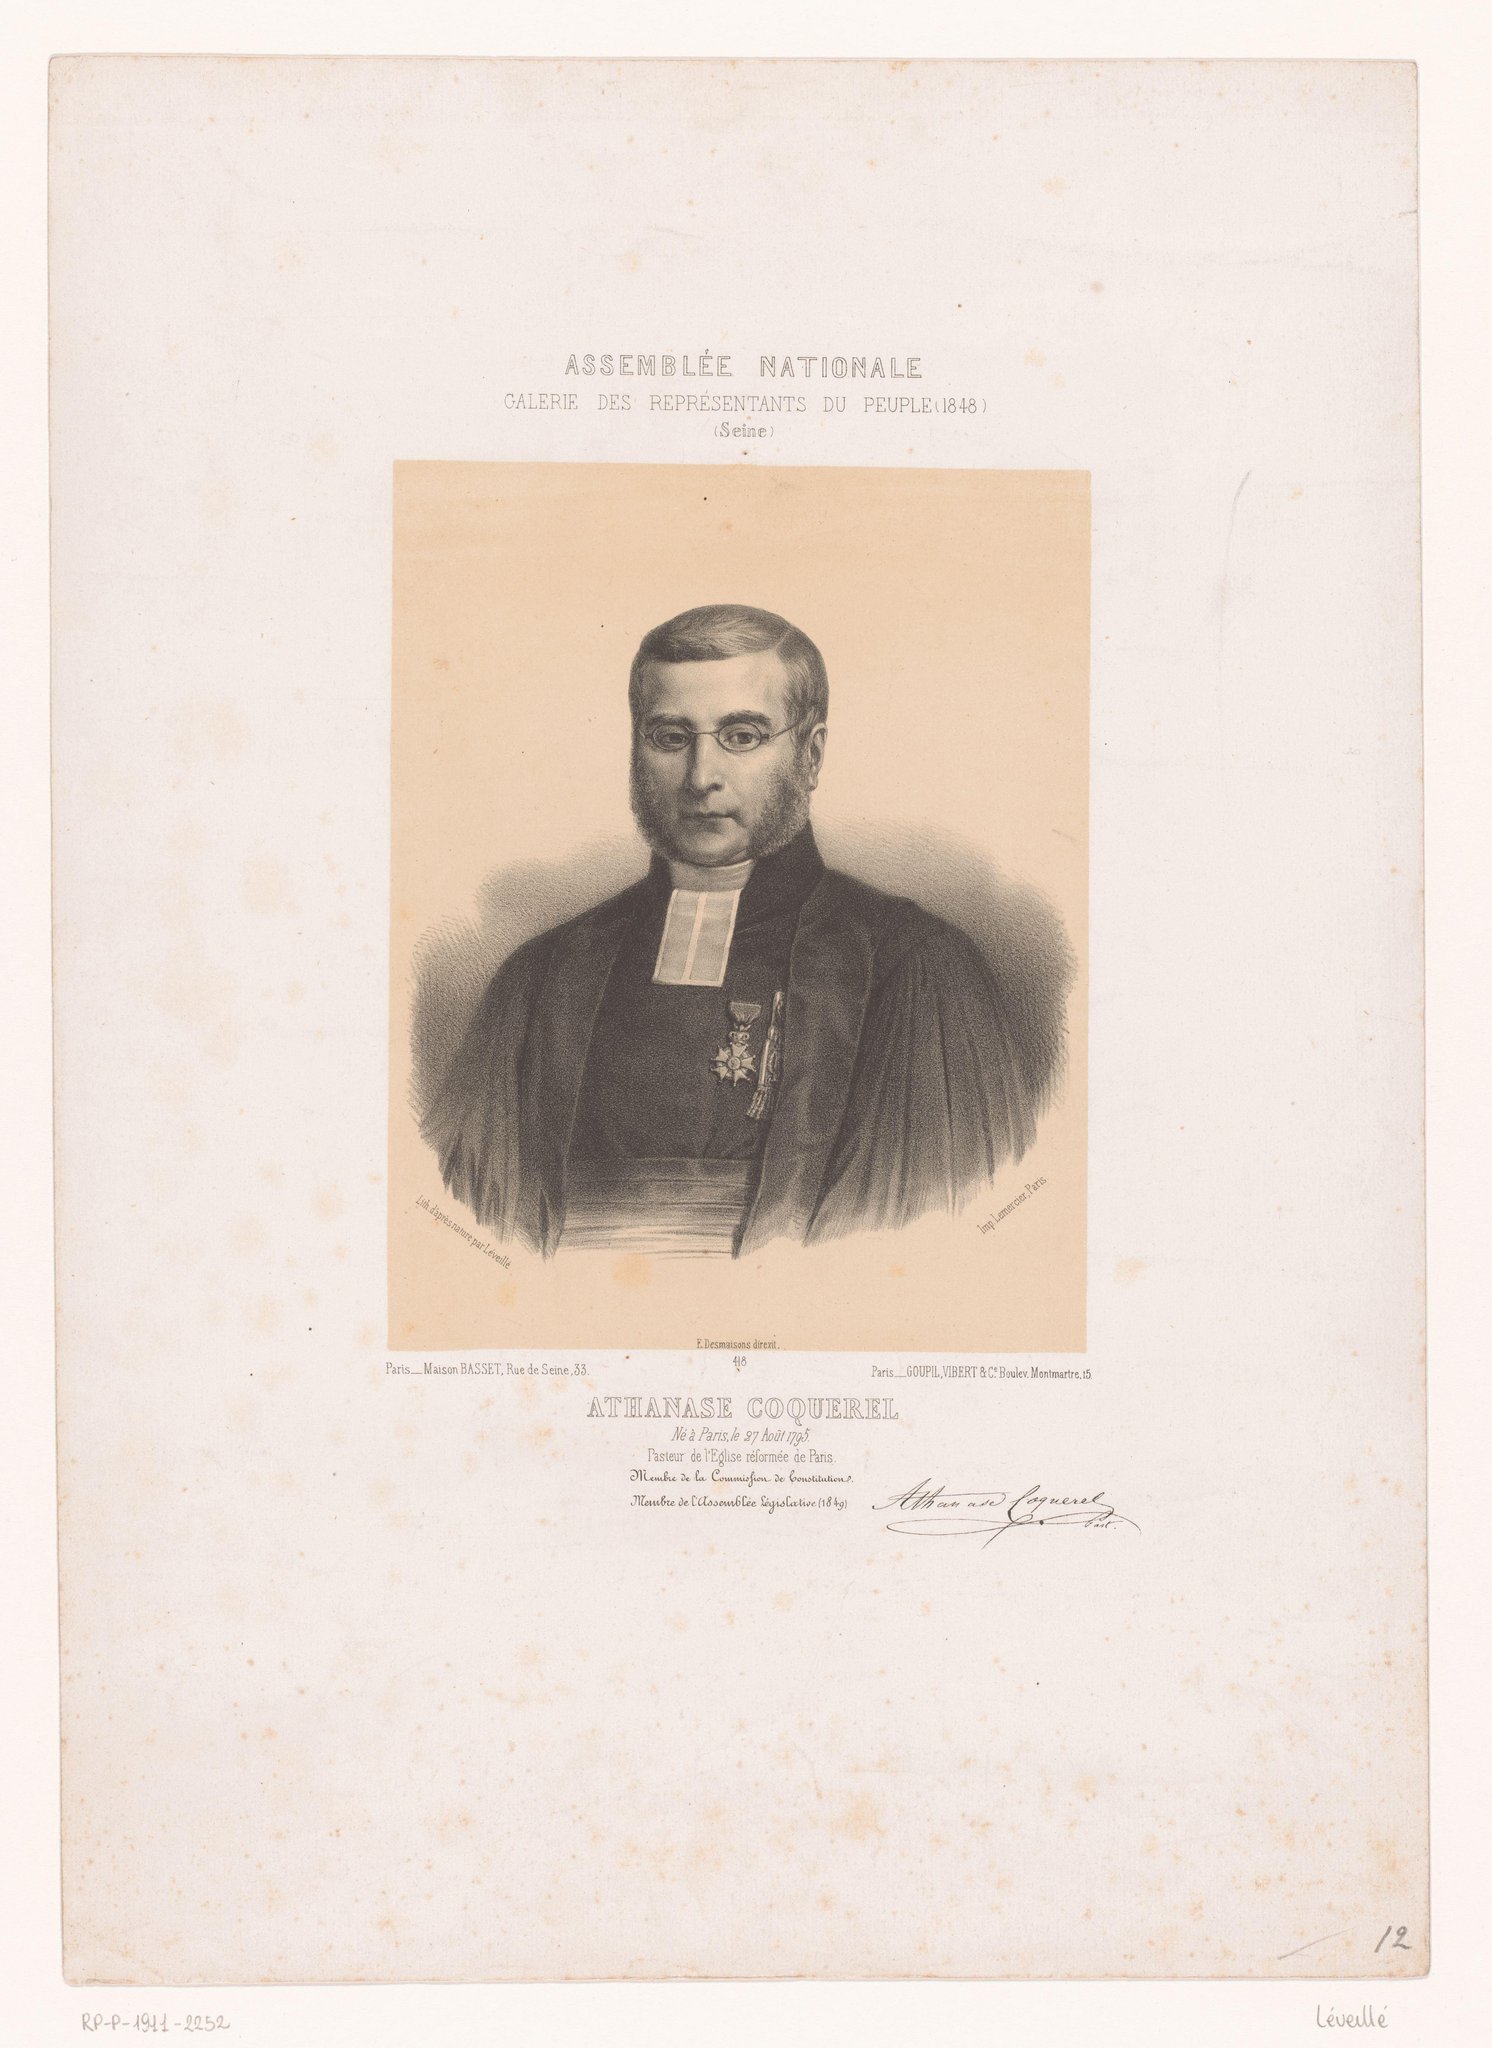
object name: print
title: Athanase Coquerel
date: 1848-1849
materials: paper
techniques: lithograph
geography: paris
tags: historical persons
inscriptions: collector's mark: Lugt 2228a